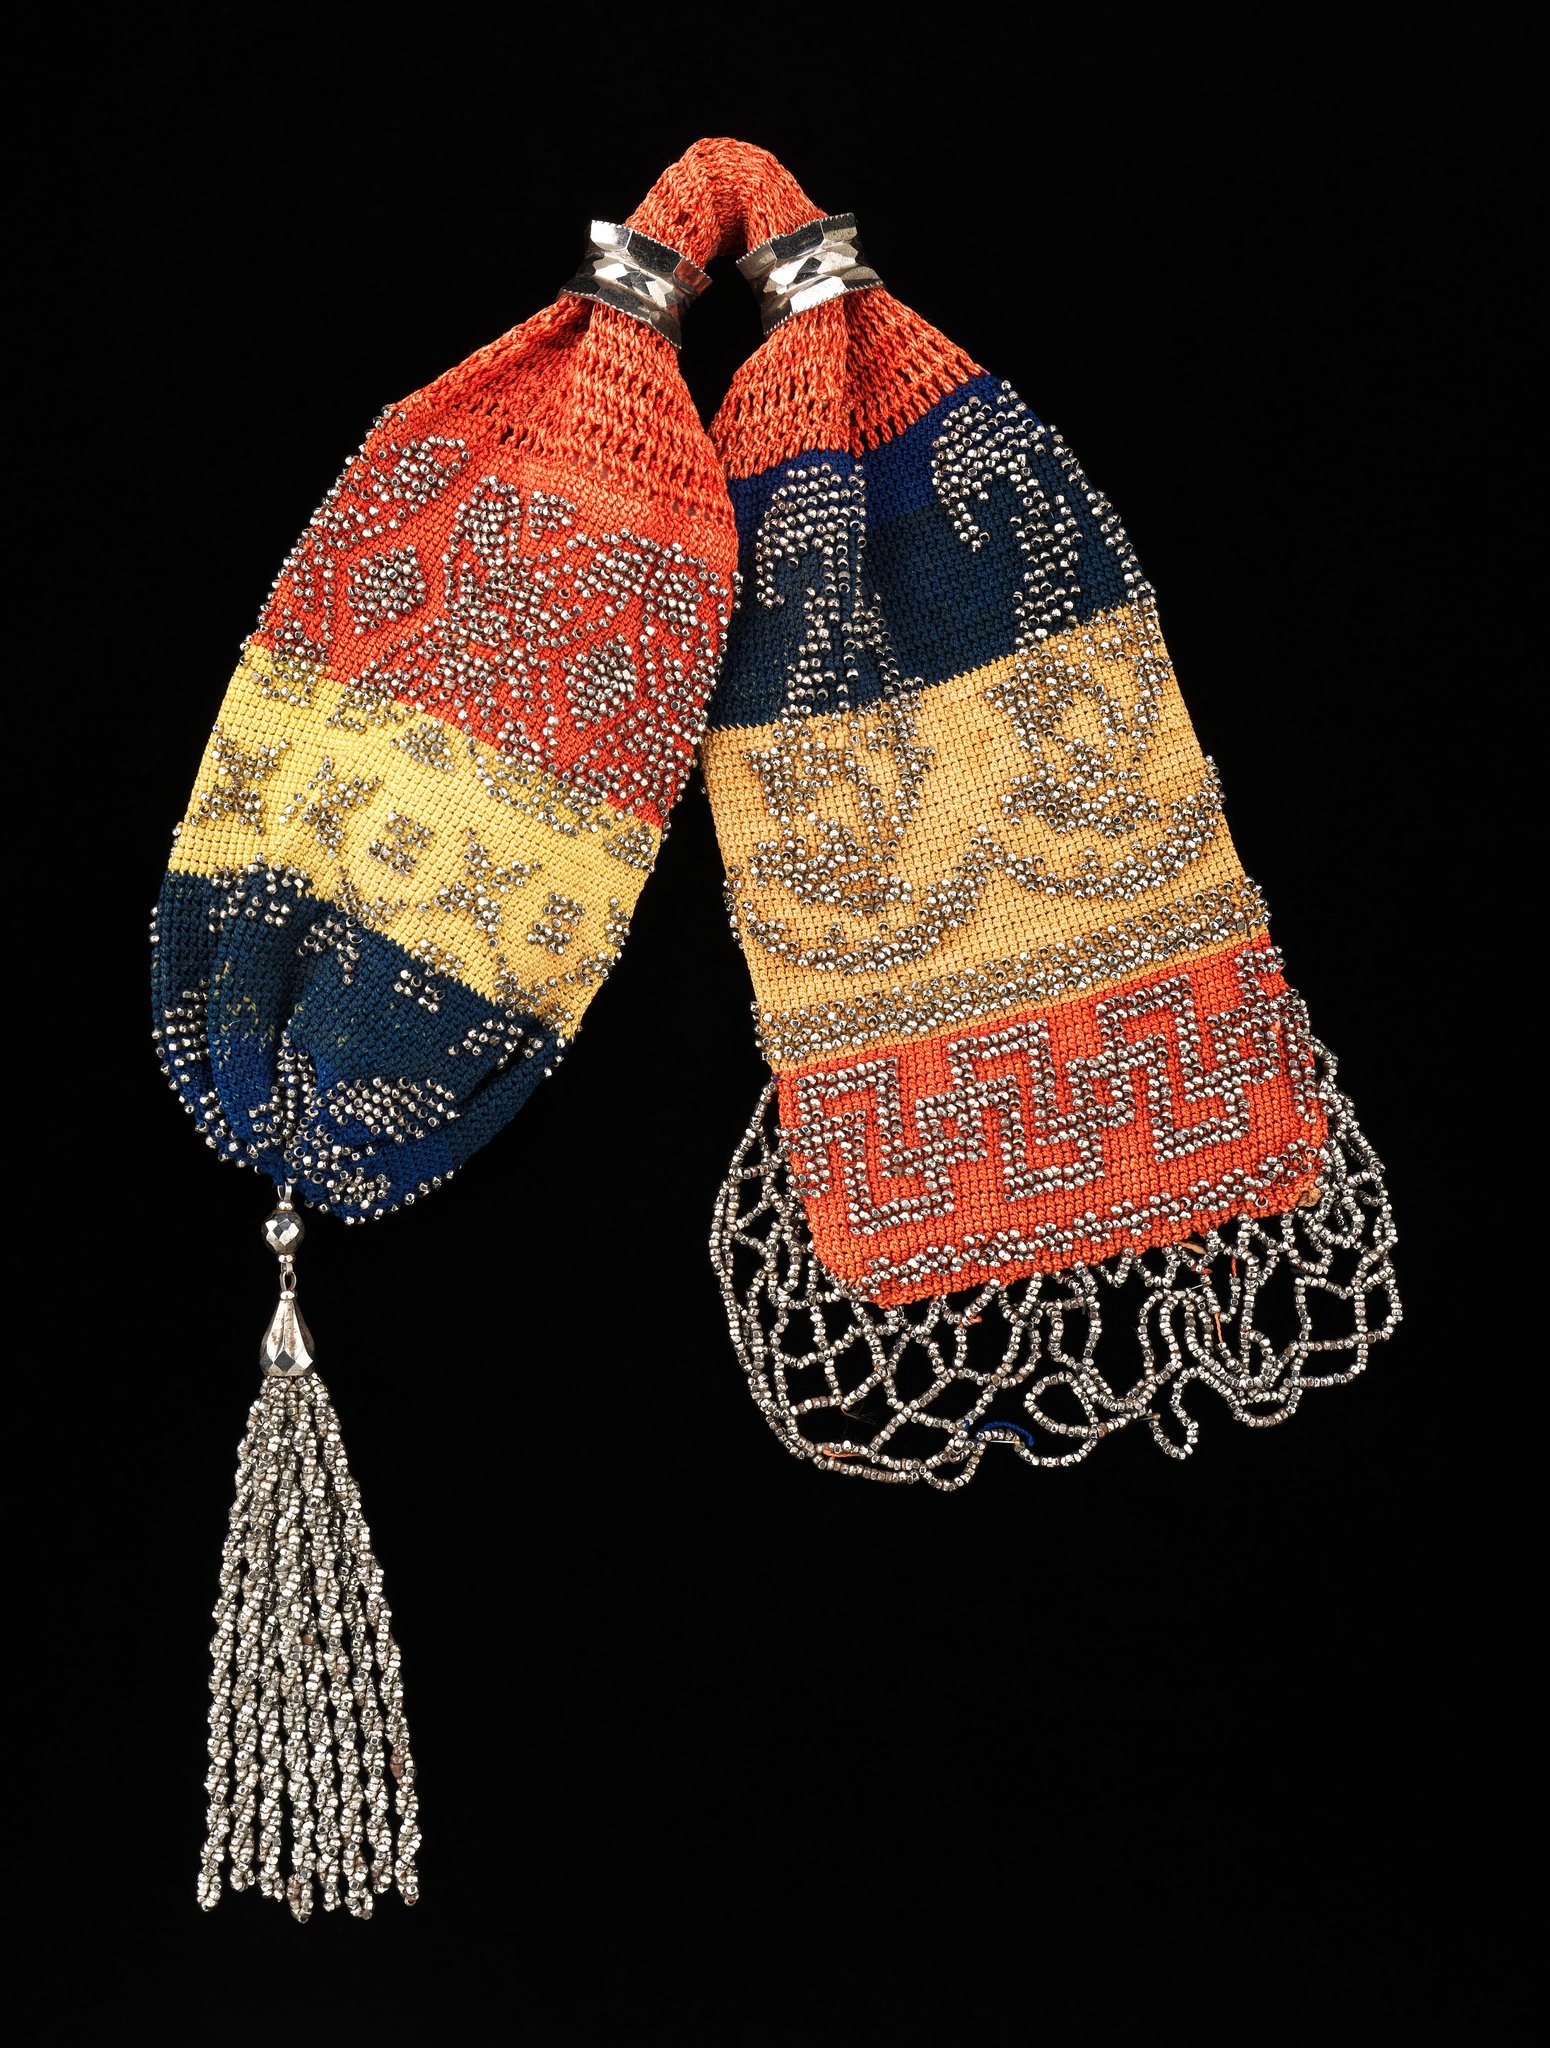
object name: miser's purse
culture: american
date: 1840-1860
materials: cotton, metal